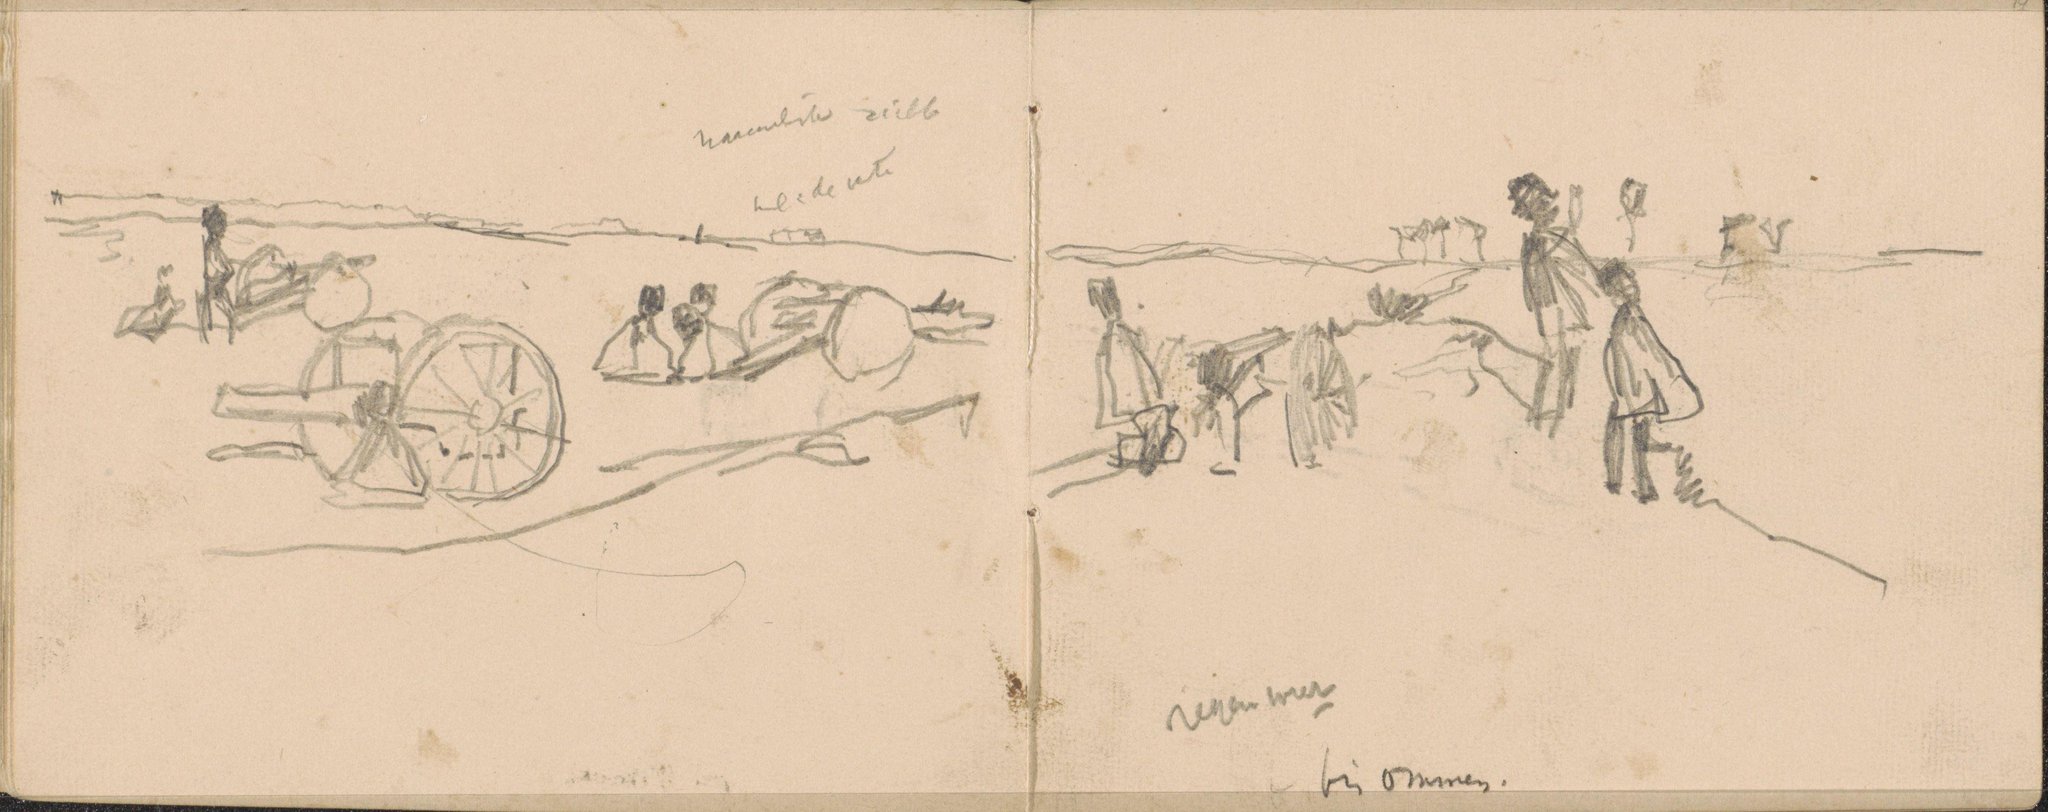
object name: sketchbook leaf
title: Rijdende artillerie op de heide nabij Ommen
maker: george hendrik breitner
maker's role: draughtsman, painter, print maker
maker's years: 1857-1923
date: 1885-1898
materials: paper, pencil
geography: ommen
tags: landscapes, firearms: cannon, the soldier; the soldier's life (+ artillery)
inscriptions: annotation: ‘regen weer/ bij Ommen.’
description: Pagina 13 en pagina 14 uit een schetsboek met 32 bladen.